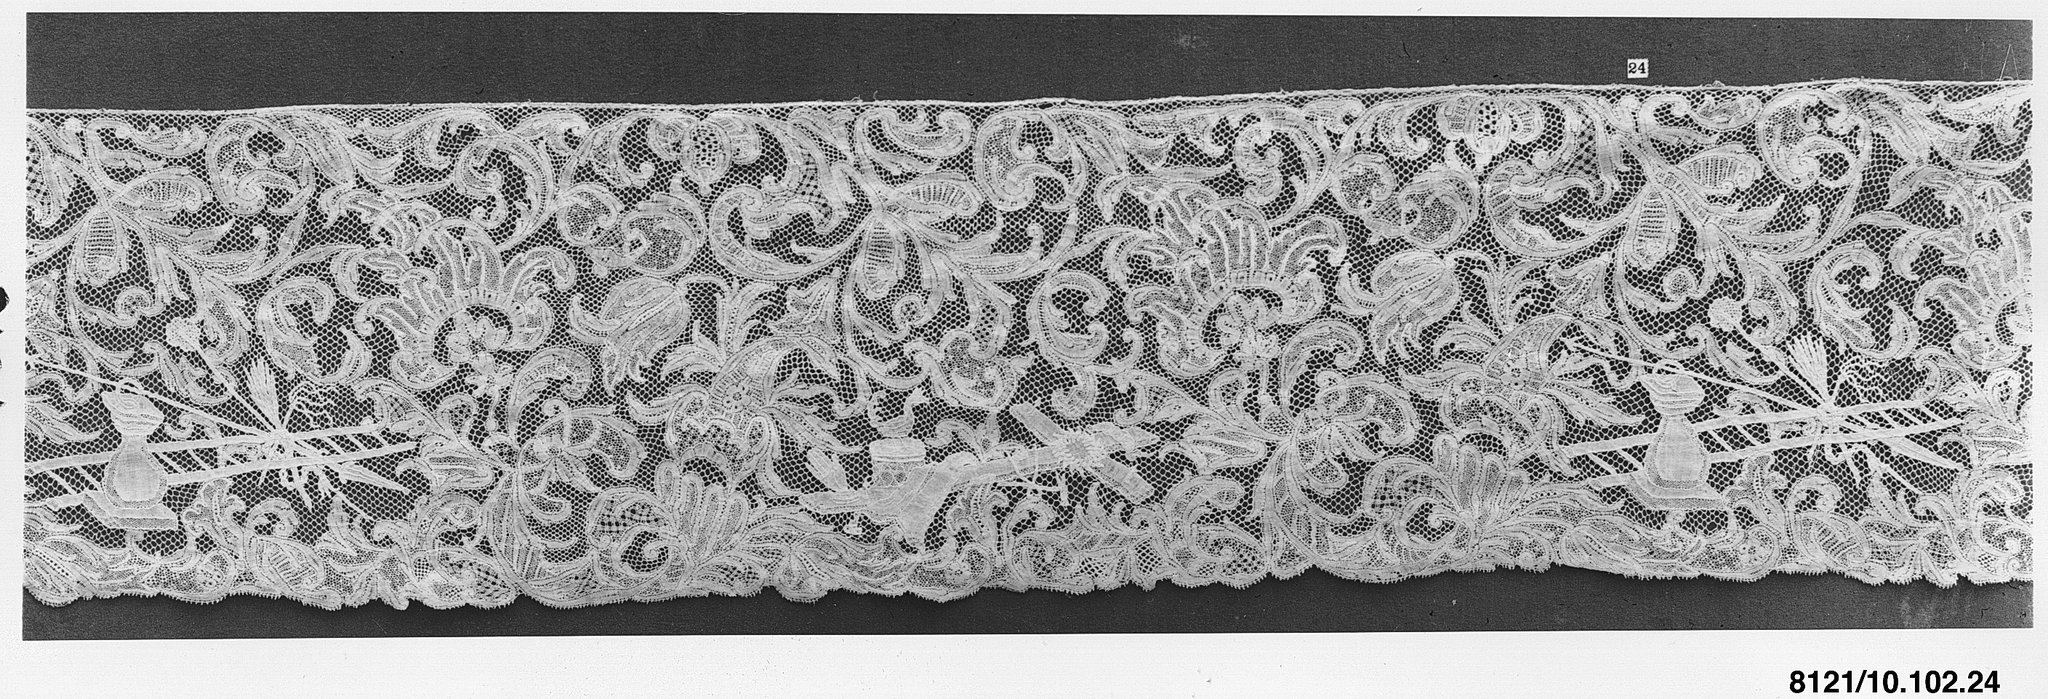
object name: flounce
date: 1701-1733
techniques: lace